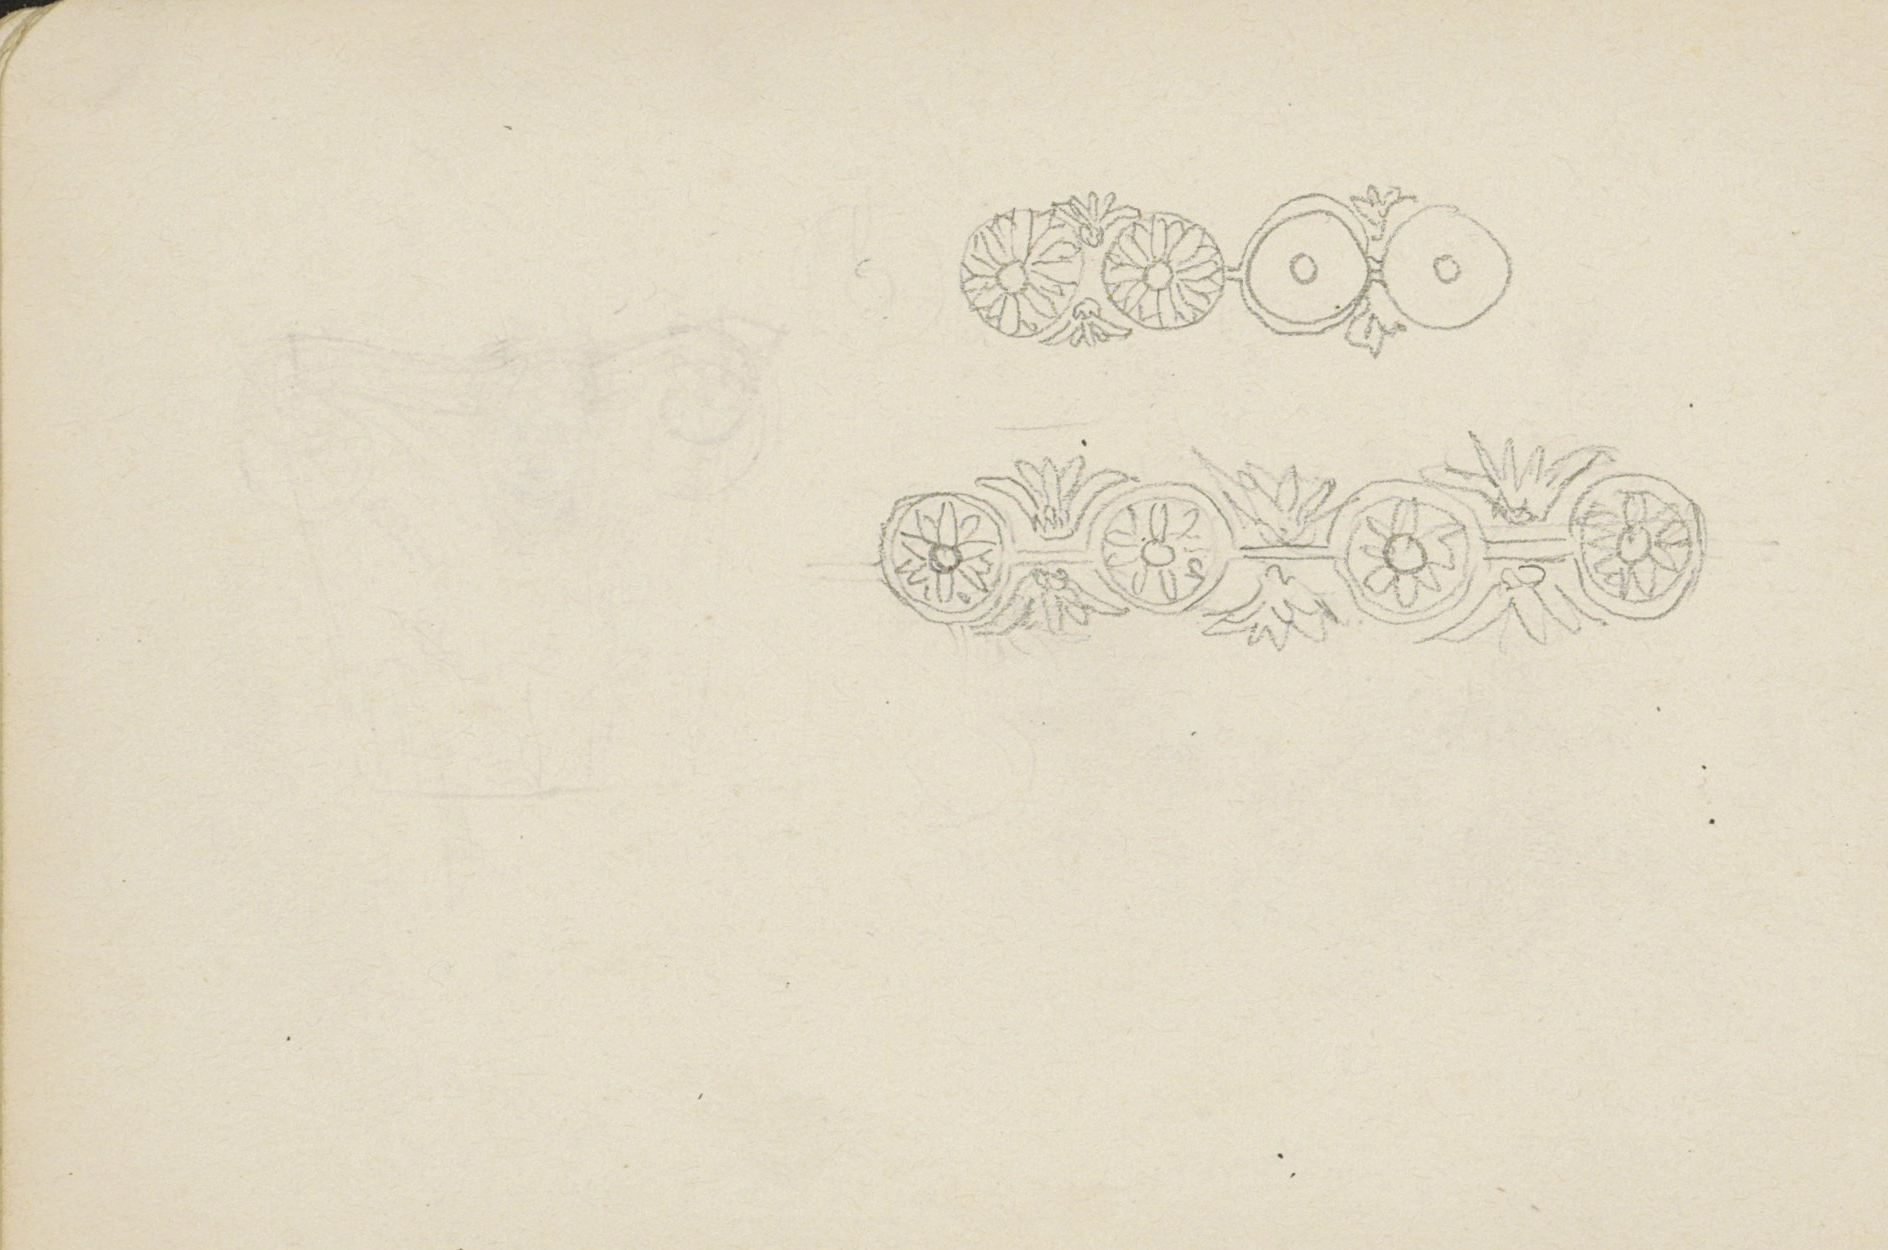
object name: sketchbook leaf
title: Floraal motief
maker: julie de graag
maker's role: draughtsman, print maker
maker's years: 1877-1924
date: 1894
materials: paper, pencil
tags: floral interlace ~ ornament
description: Blad 18 verso uit een schetsboek met 35 bladen.